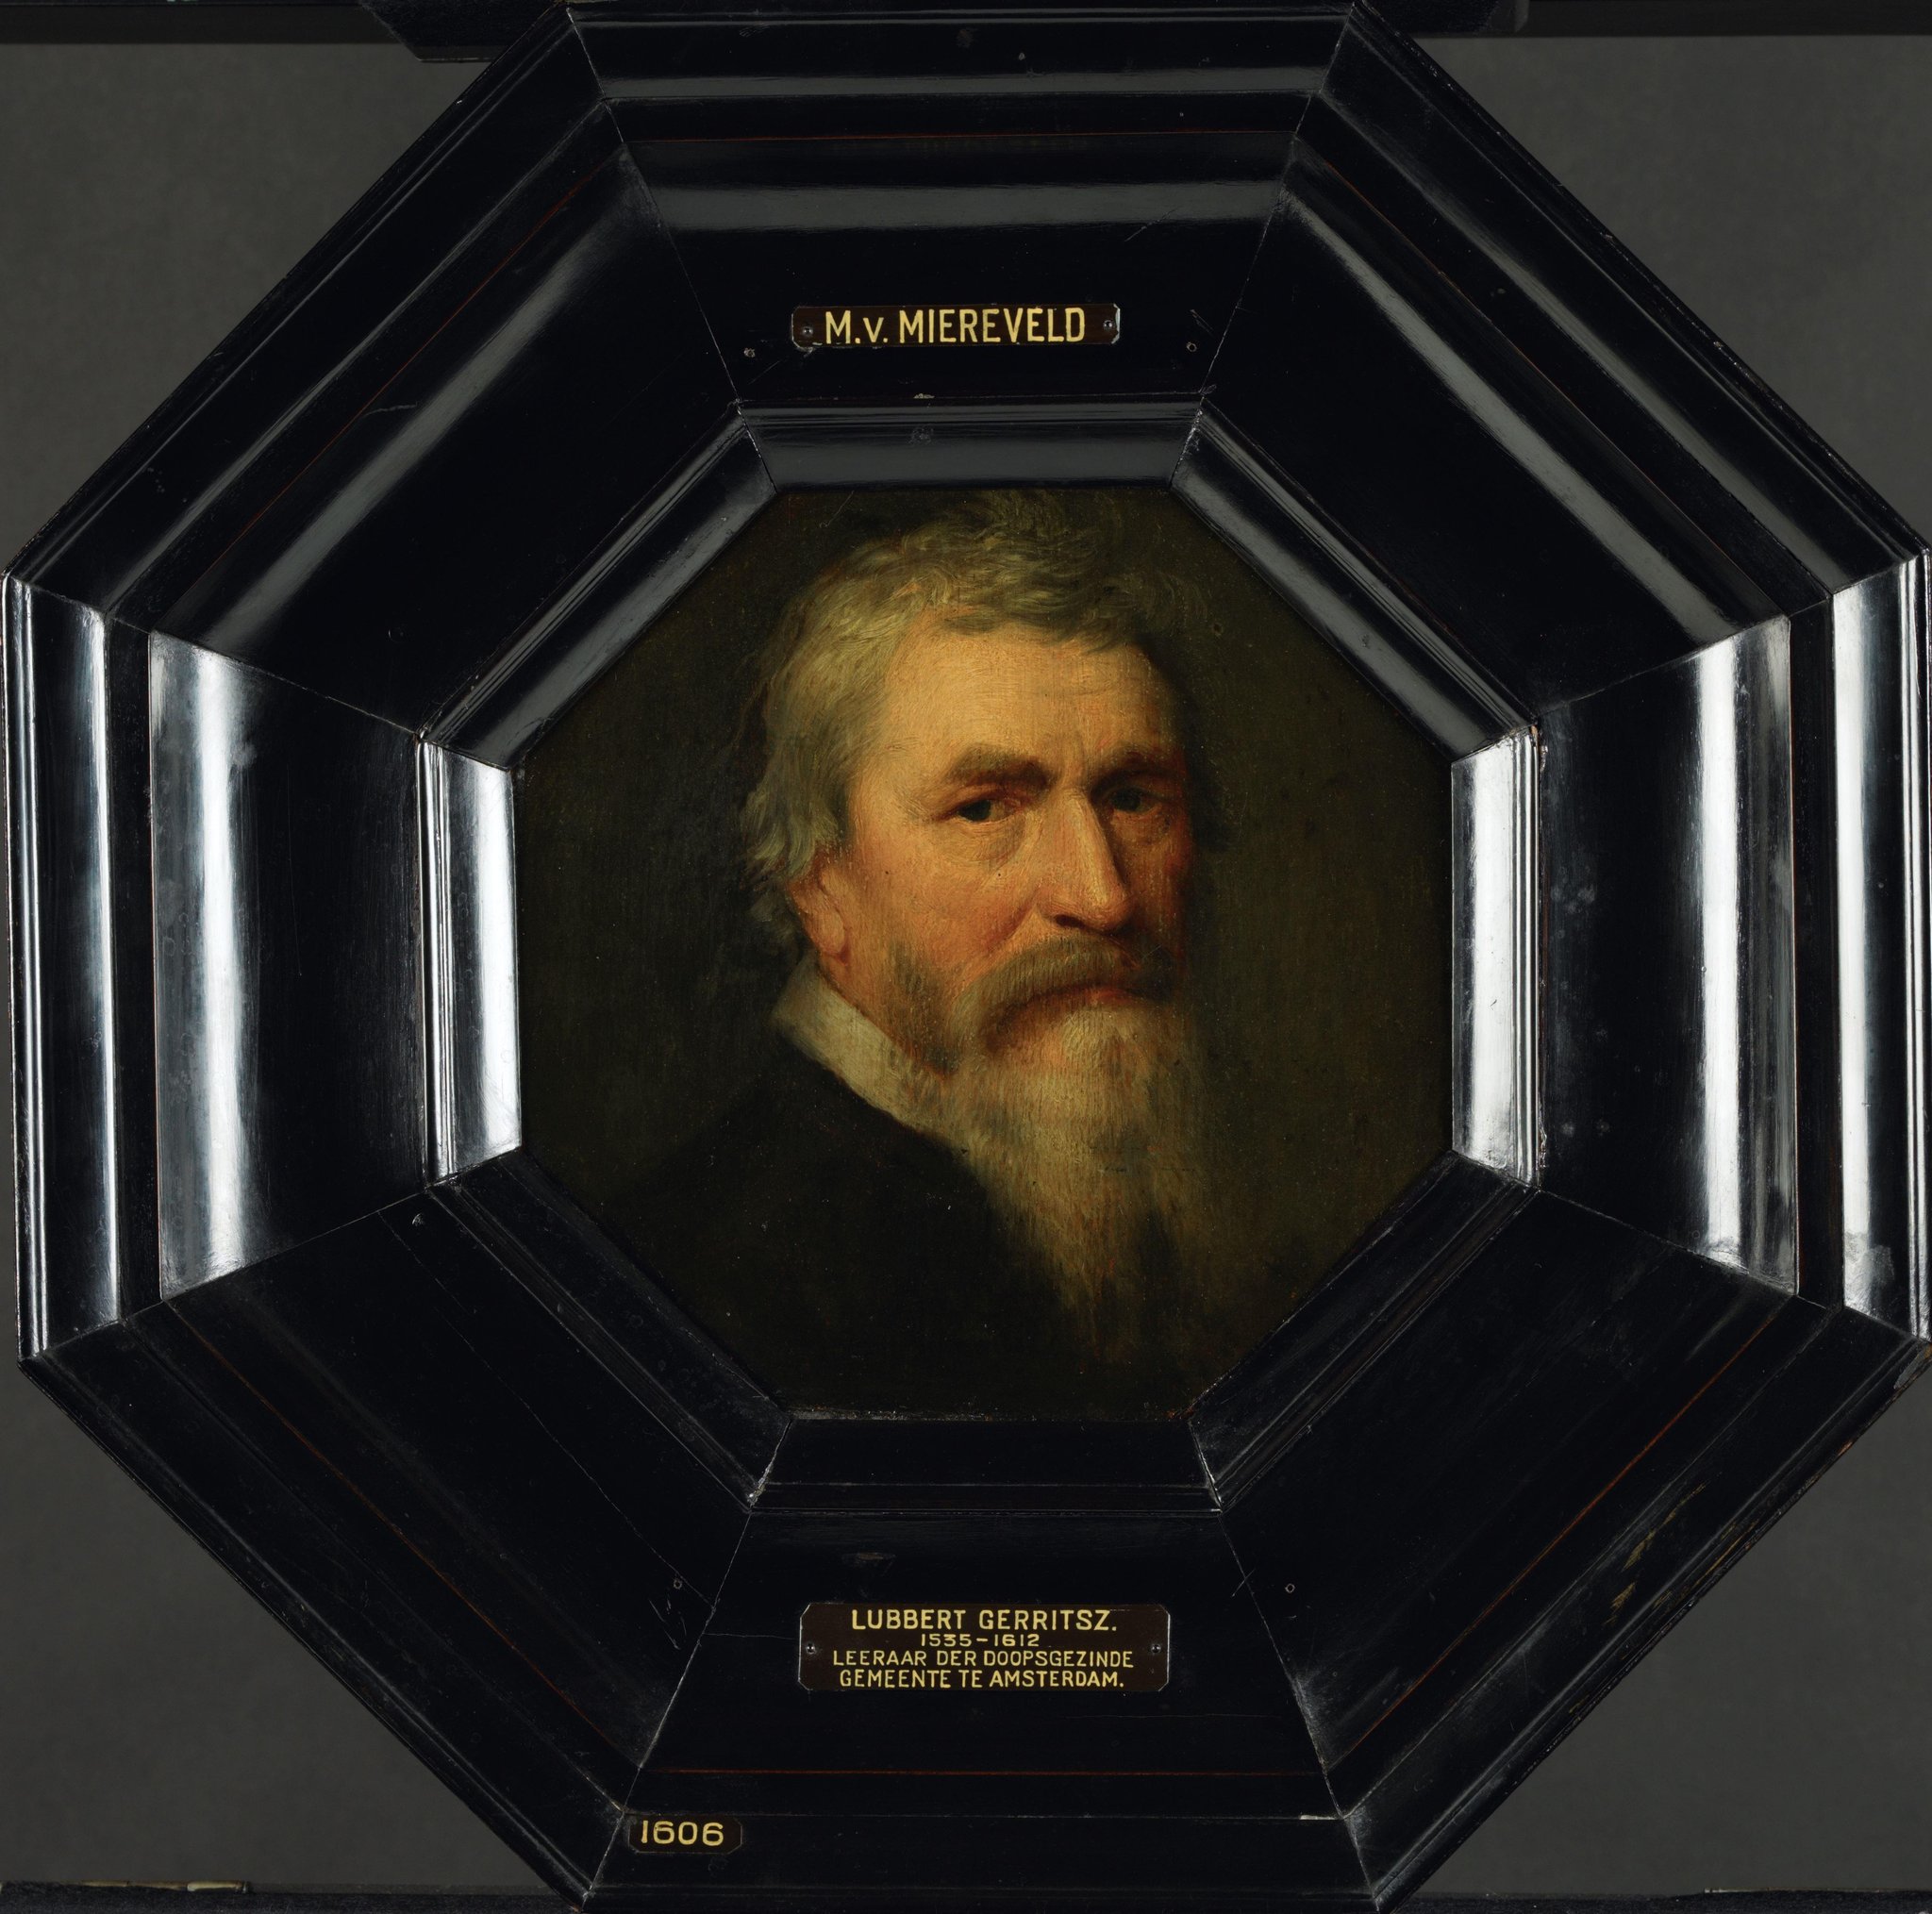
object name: painting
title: Portrait of Lubbert Gerritsz (1535-1612)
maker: michiel jansz van mierevelt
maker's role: draughtsman, painter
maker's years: 1567-1641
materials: oil, panel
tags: amsterdam, functionaries and dignitaries (with name) ~ protestant churches, theologian, historical persons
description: Portret van Lubbert Gerritsz, leraar der Doopsgezinden te Amsterdam. Buste naar rechts.